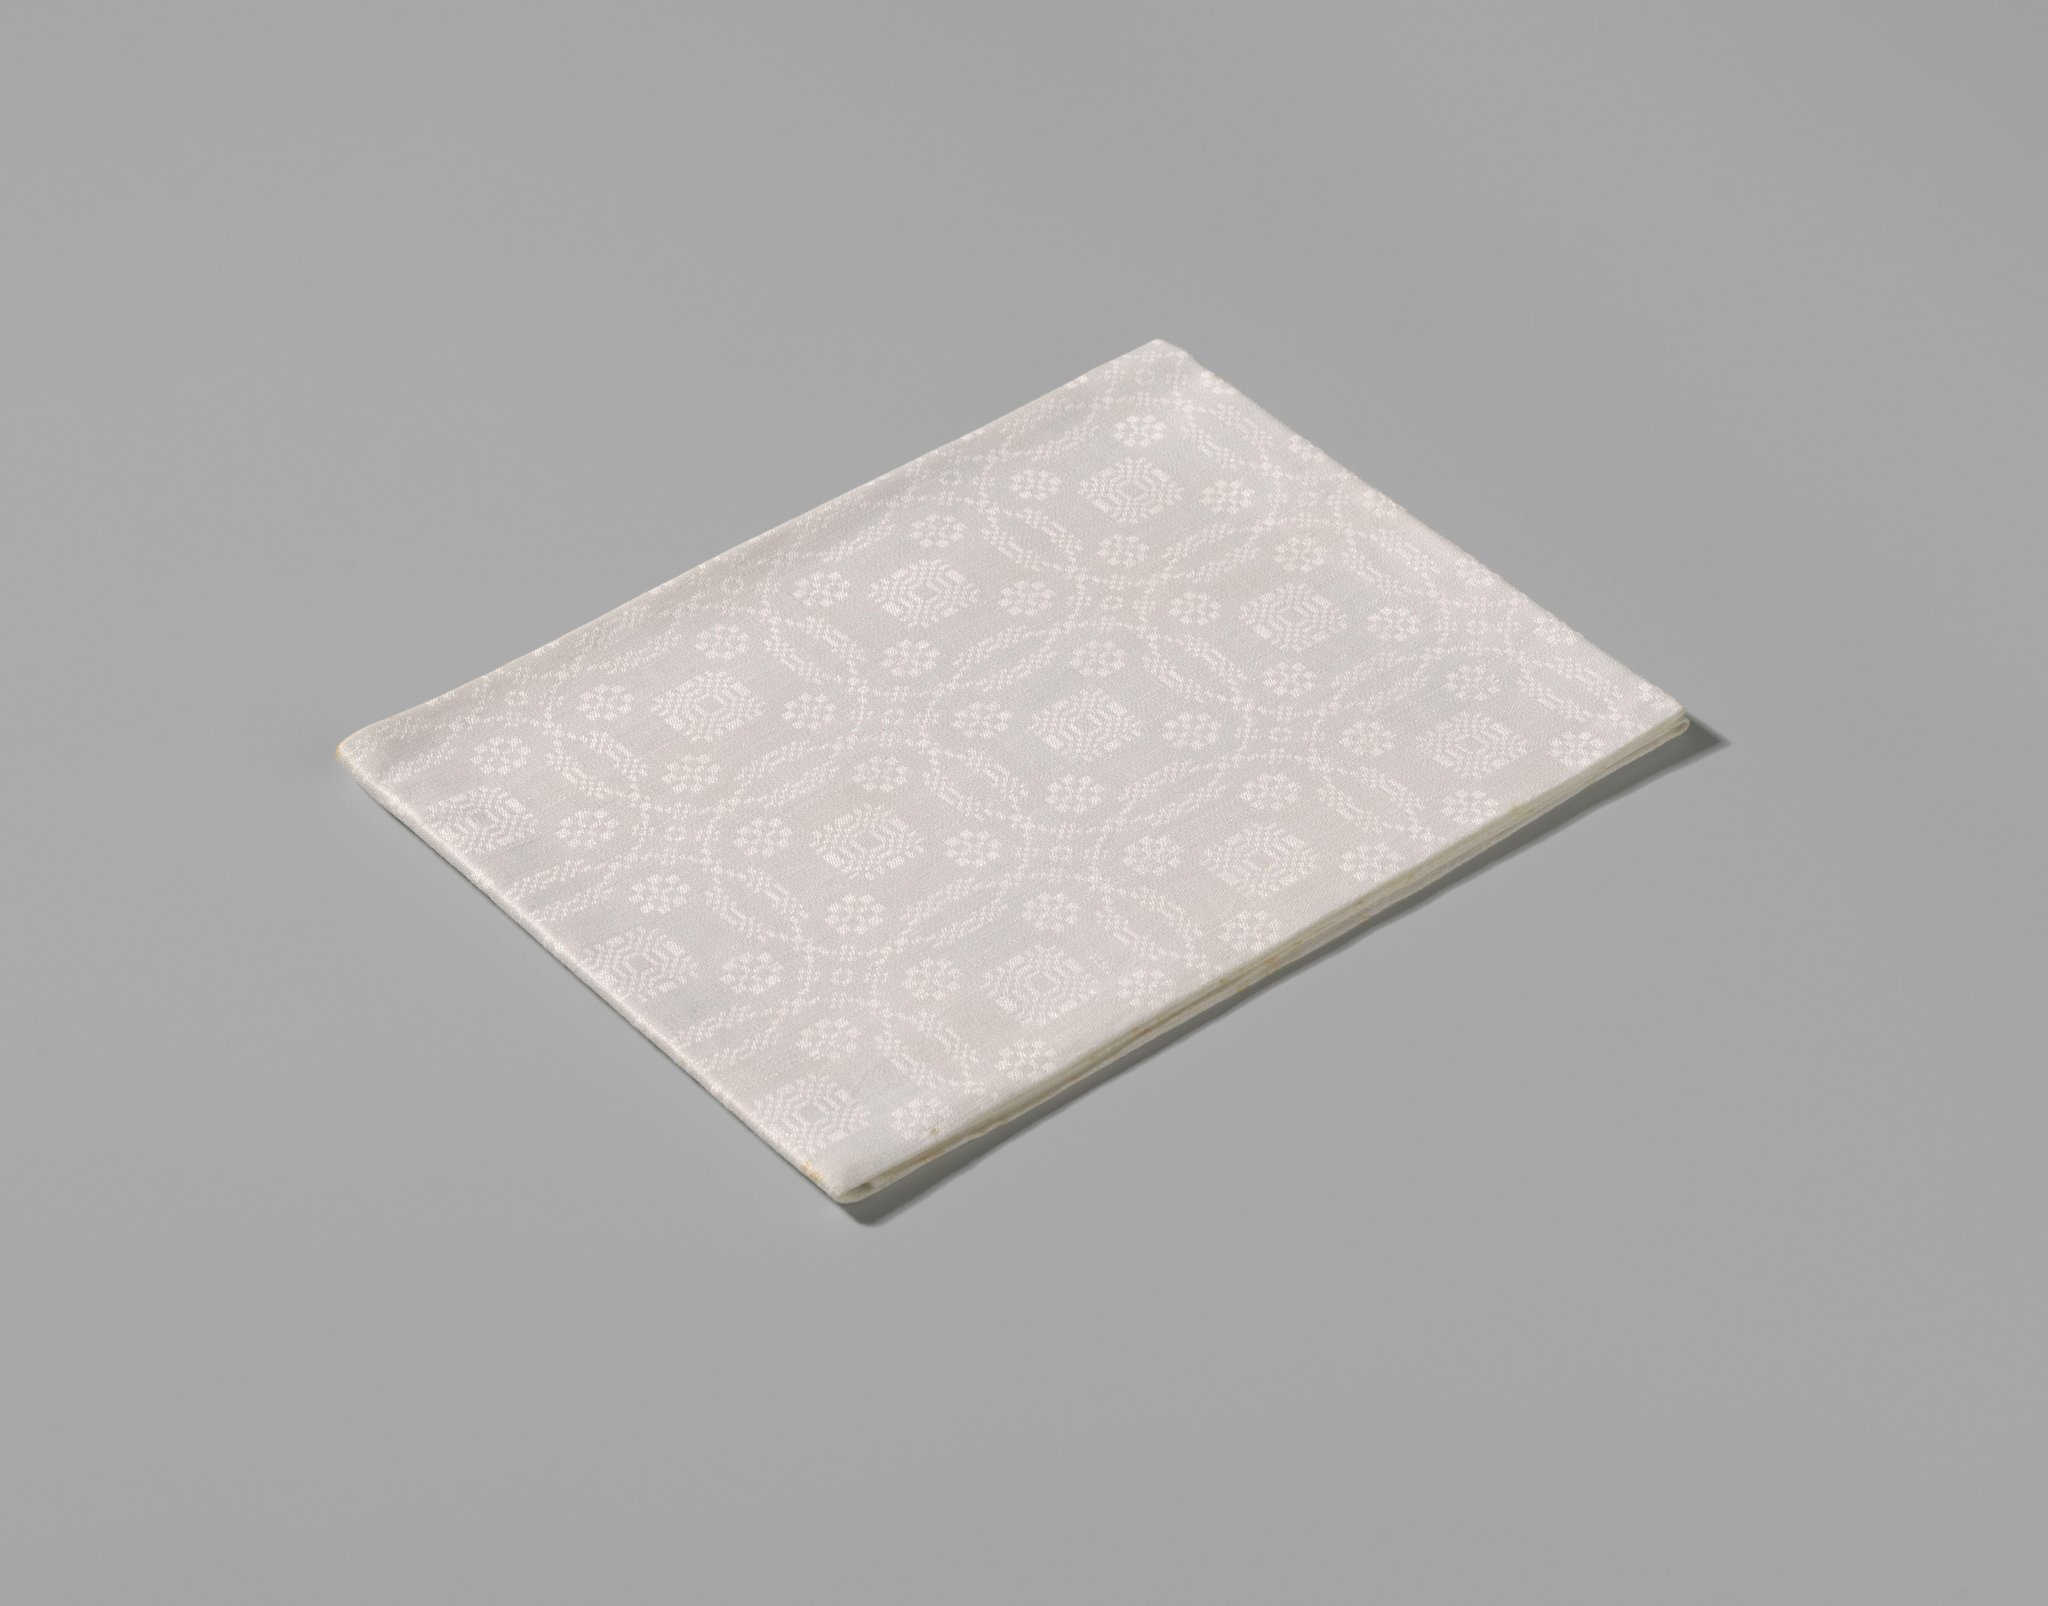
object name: napkin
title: Servet van pellendamast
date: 1750-1799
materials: linen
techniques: weave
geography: netherlands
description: Wit linnen servet van pellendamast, merk PH 12 WH 2oonl. Het patroon heeft cirkels waarbinnen geblokte rozetten.